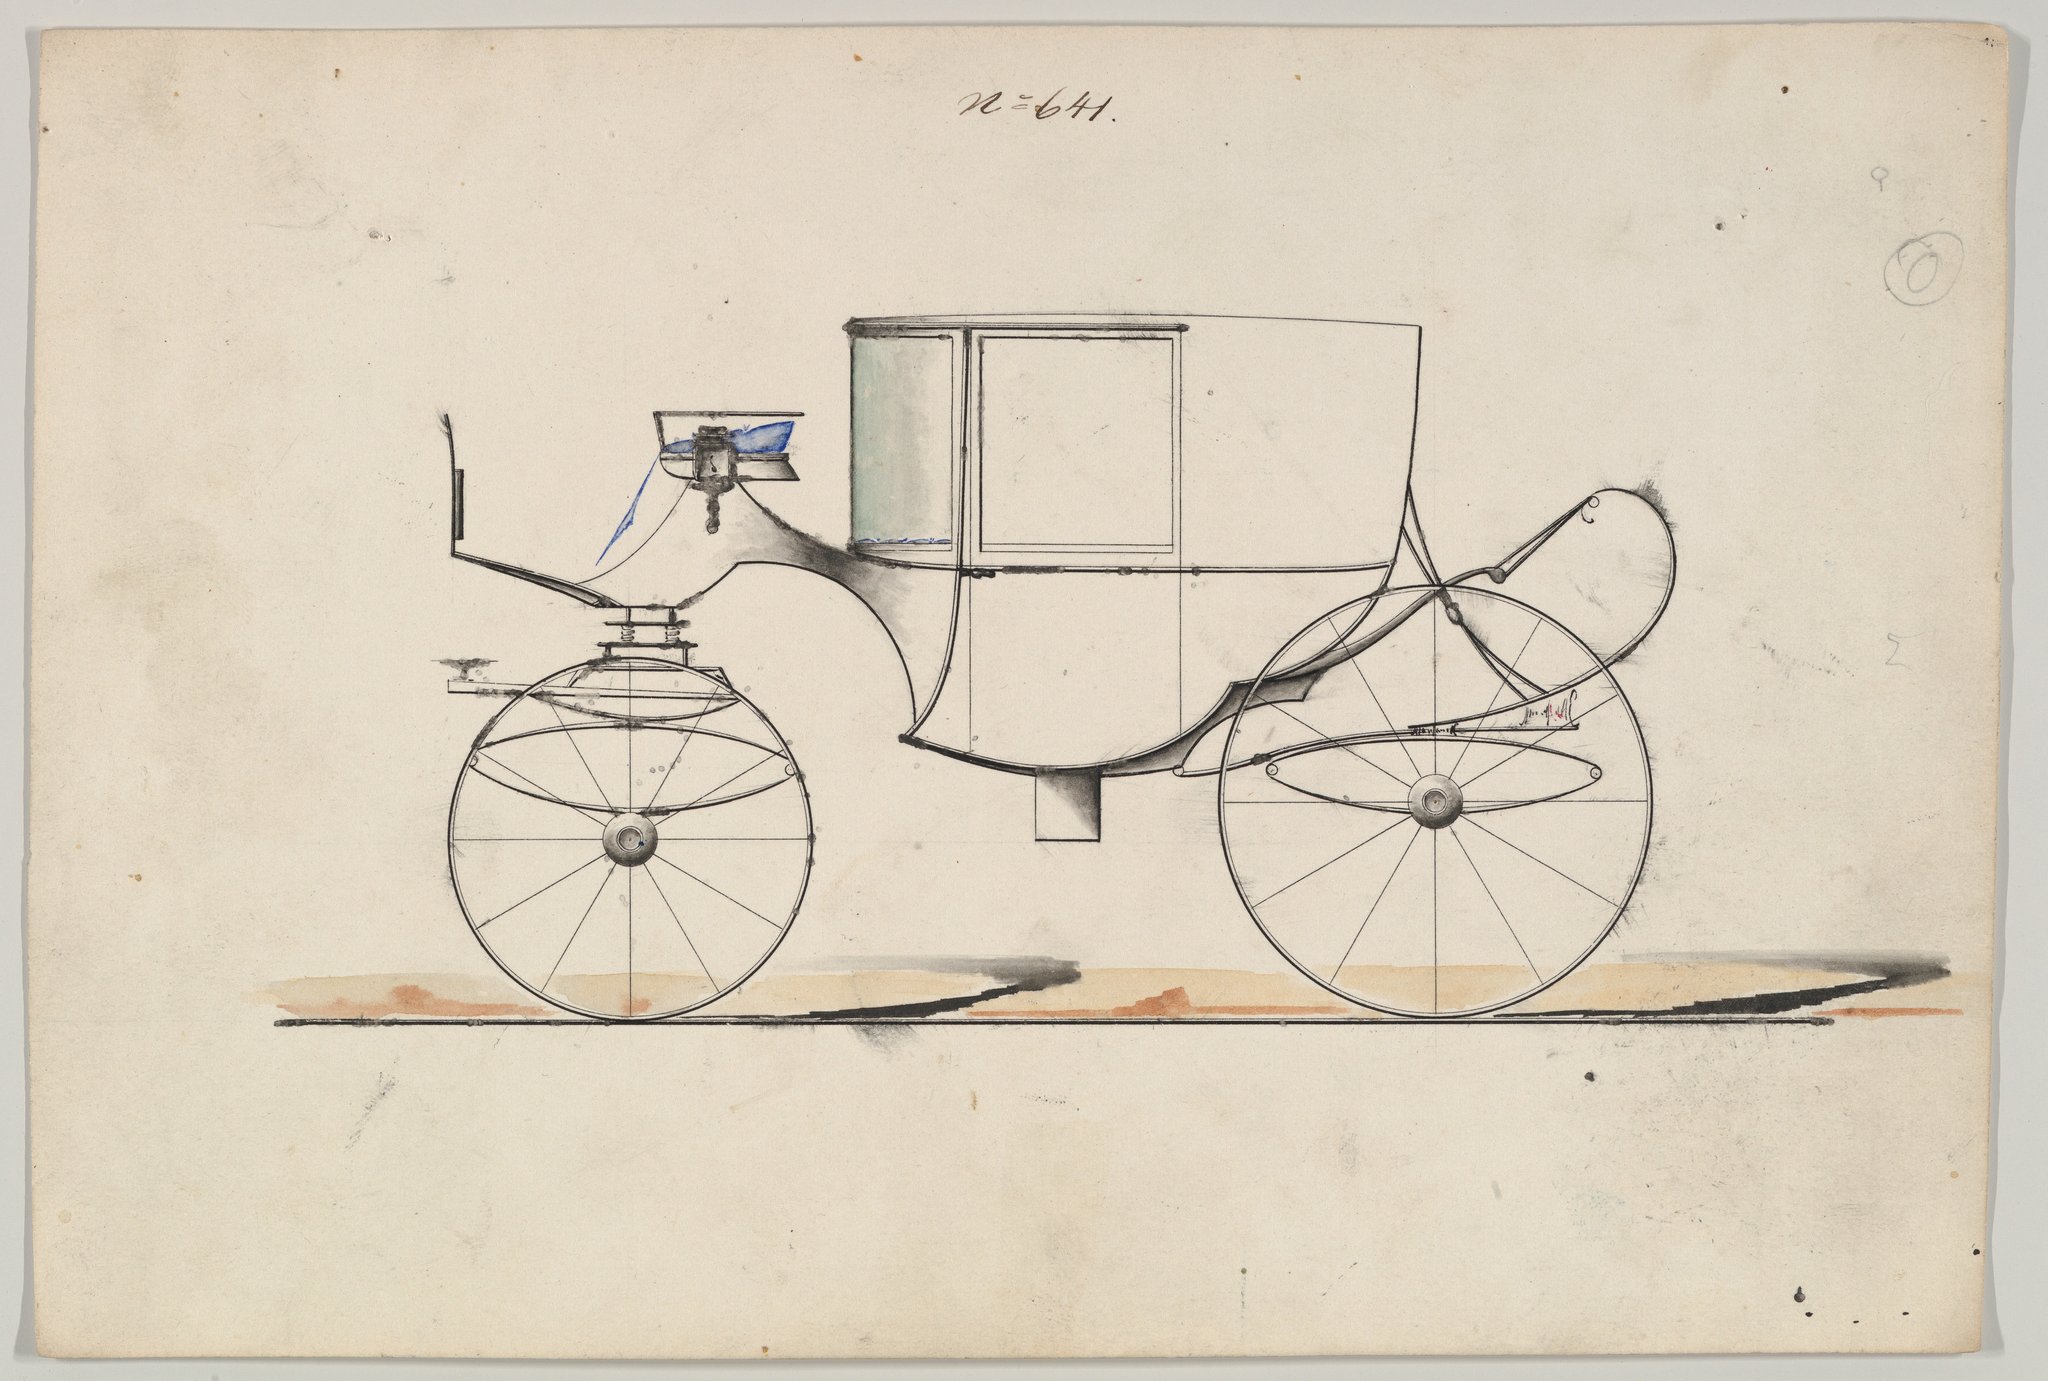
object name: drawing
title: Coupé # 641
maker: brewster & co.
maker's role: manufacturer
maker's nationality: american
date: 1850-1870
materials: ink, watercolor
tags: carriages